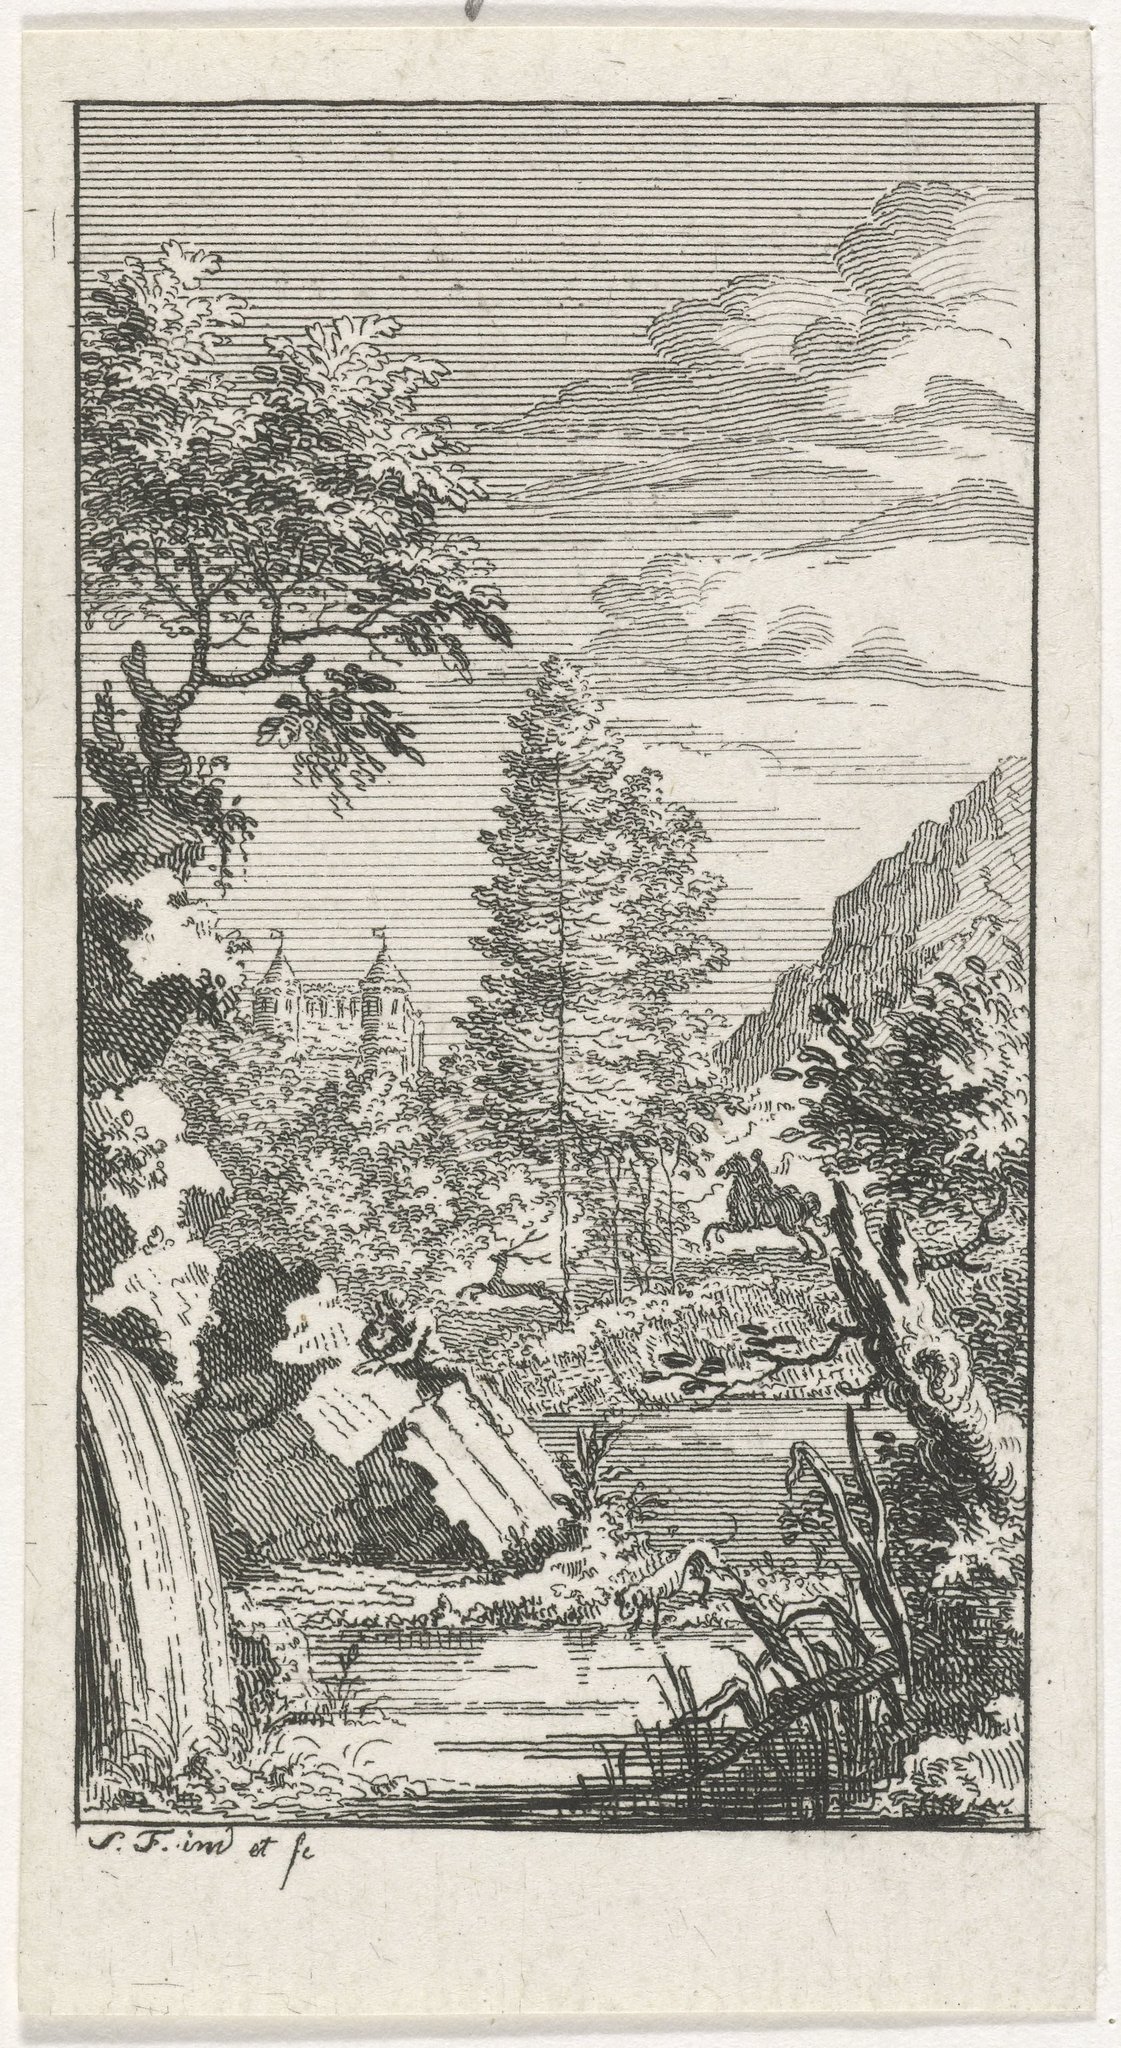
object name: print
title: De twaalf maanden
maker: simon fokke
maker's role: draughtsman, print maker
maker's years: 1712-1784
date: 1722-1784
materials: paper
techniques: etching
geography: amsterdam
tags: june ~ other concepts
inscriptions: collector's mark: Lugt 240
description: Uit een serie van twaalf prenten, de verbeelding van de maand juni. Natuurlandschap met op de achtergrond een kasteel.